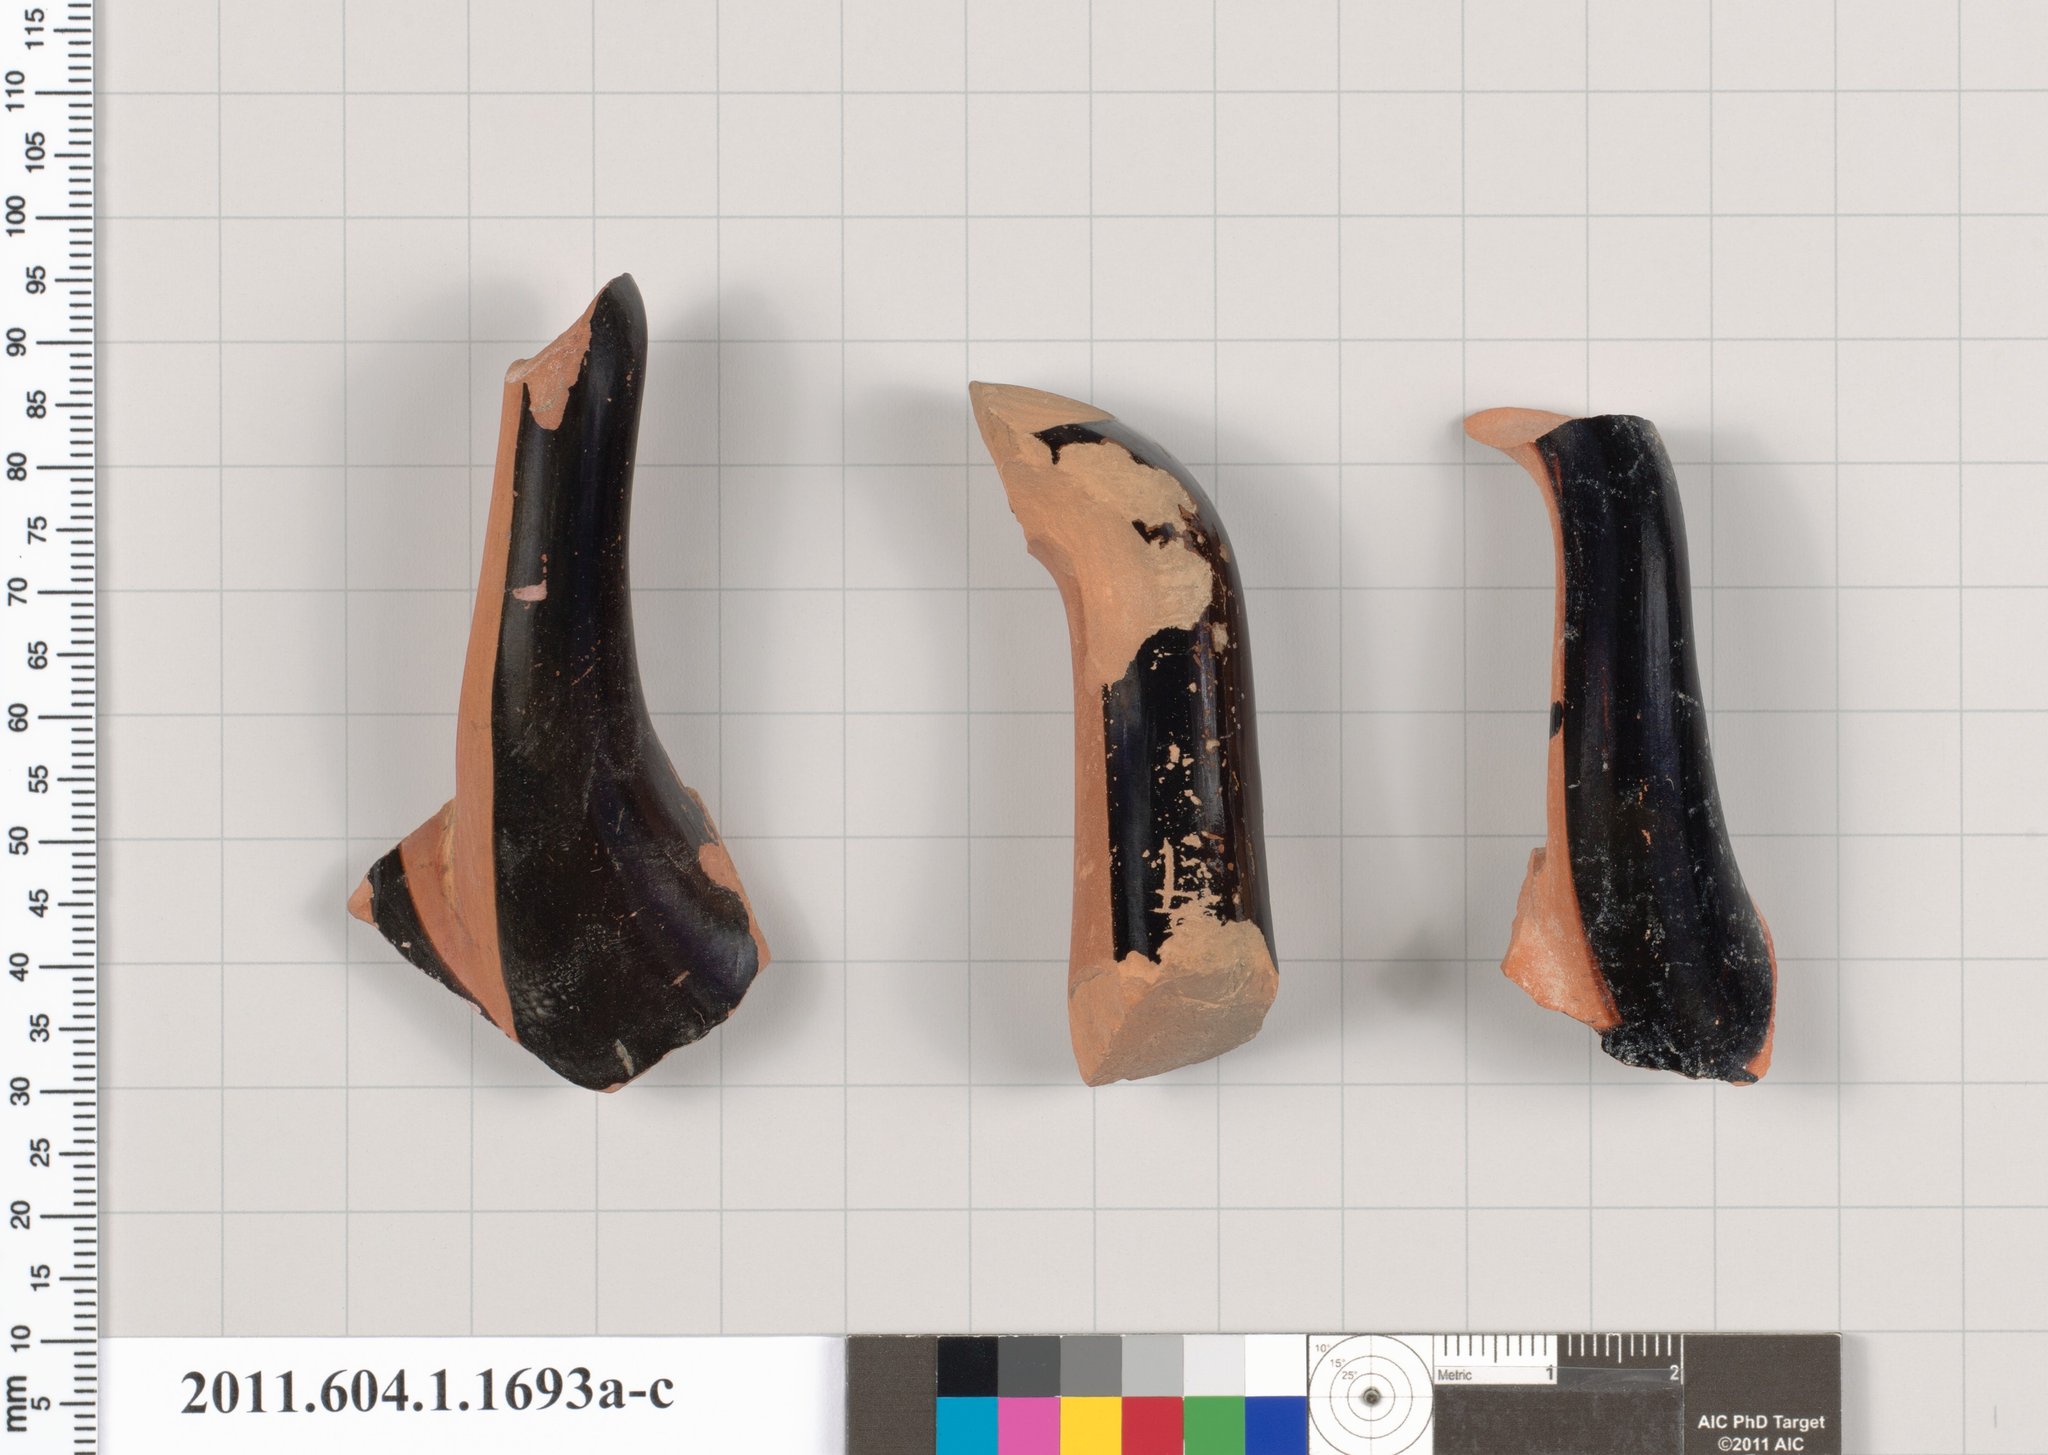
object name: kylix fragment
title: Terracotta fragments of kylikes (drinking cups)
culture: greek, attic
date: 500-401 BCE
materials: terracotta